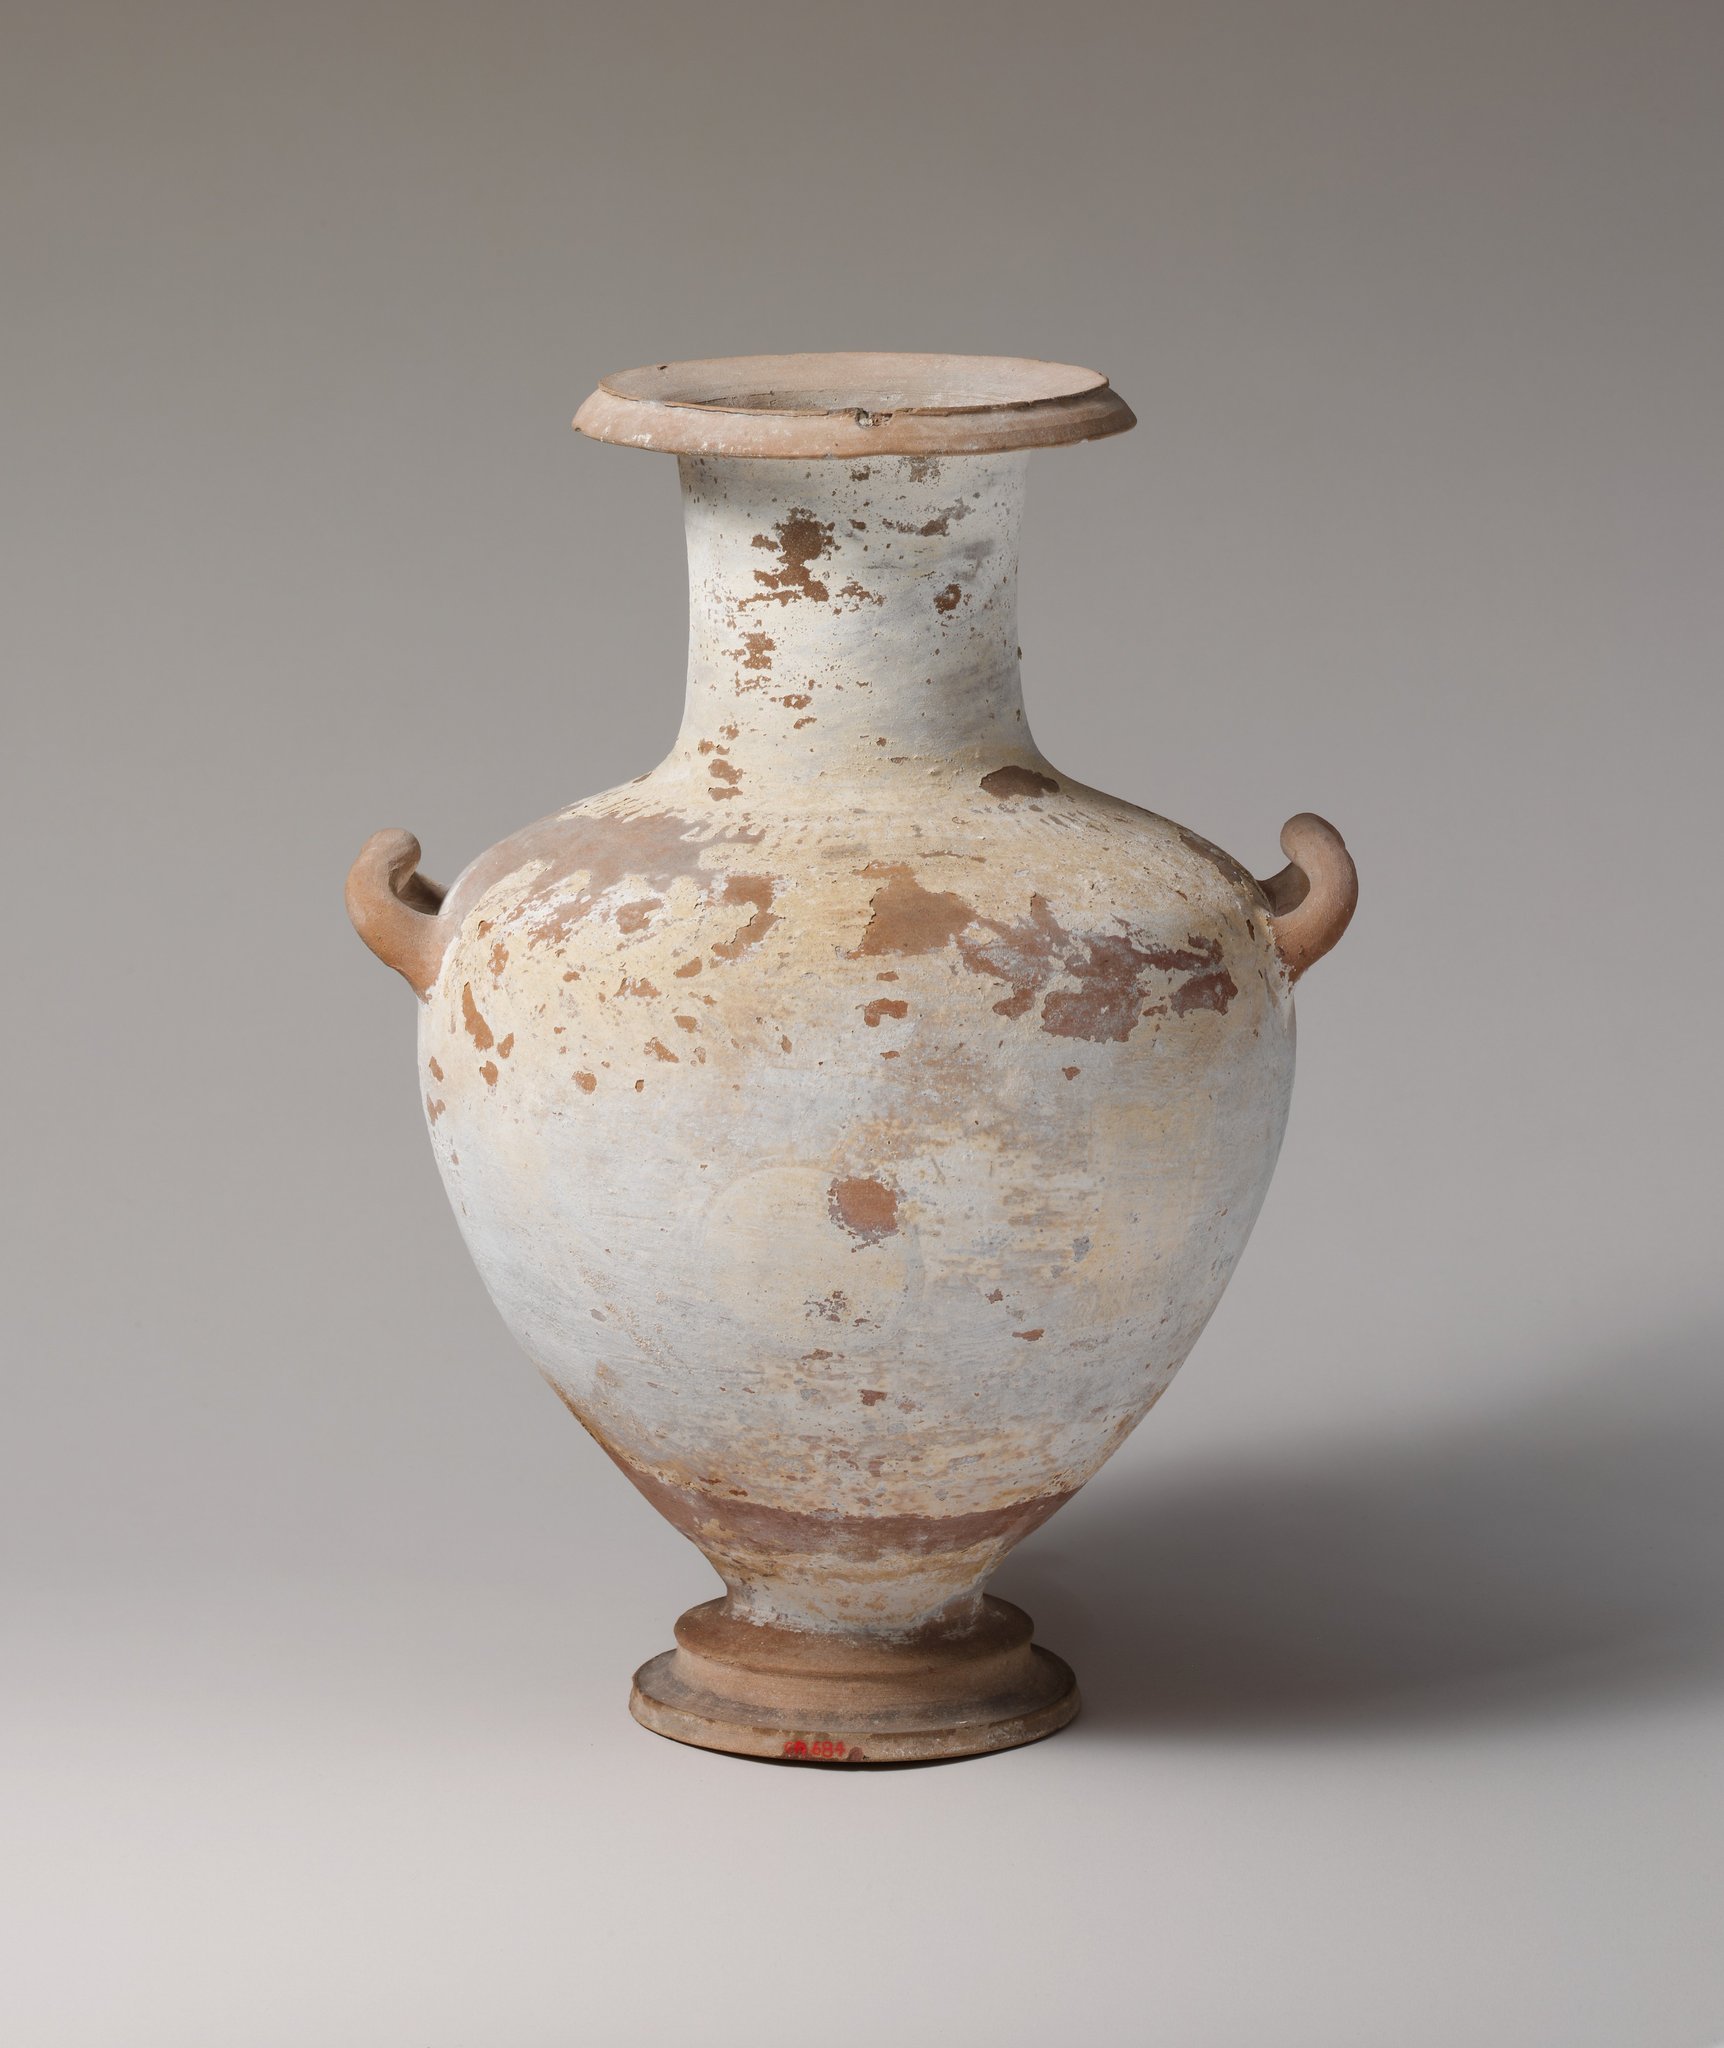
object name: hydria, hadra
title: Terracotta Hadra hydria (water jar)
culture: greek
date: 234-201 BCE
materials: terracotta